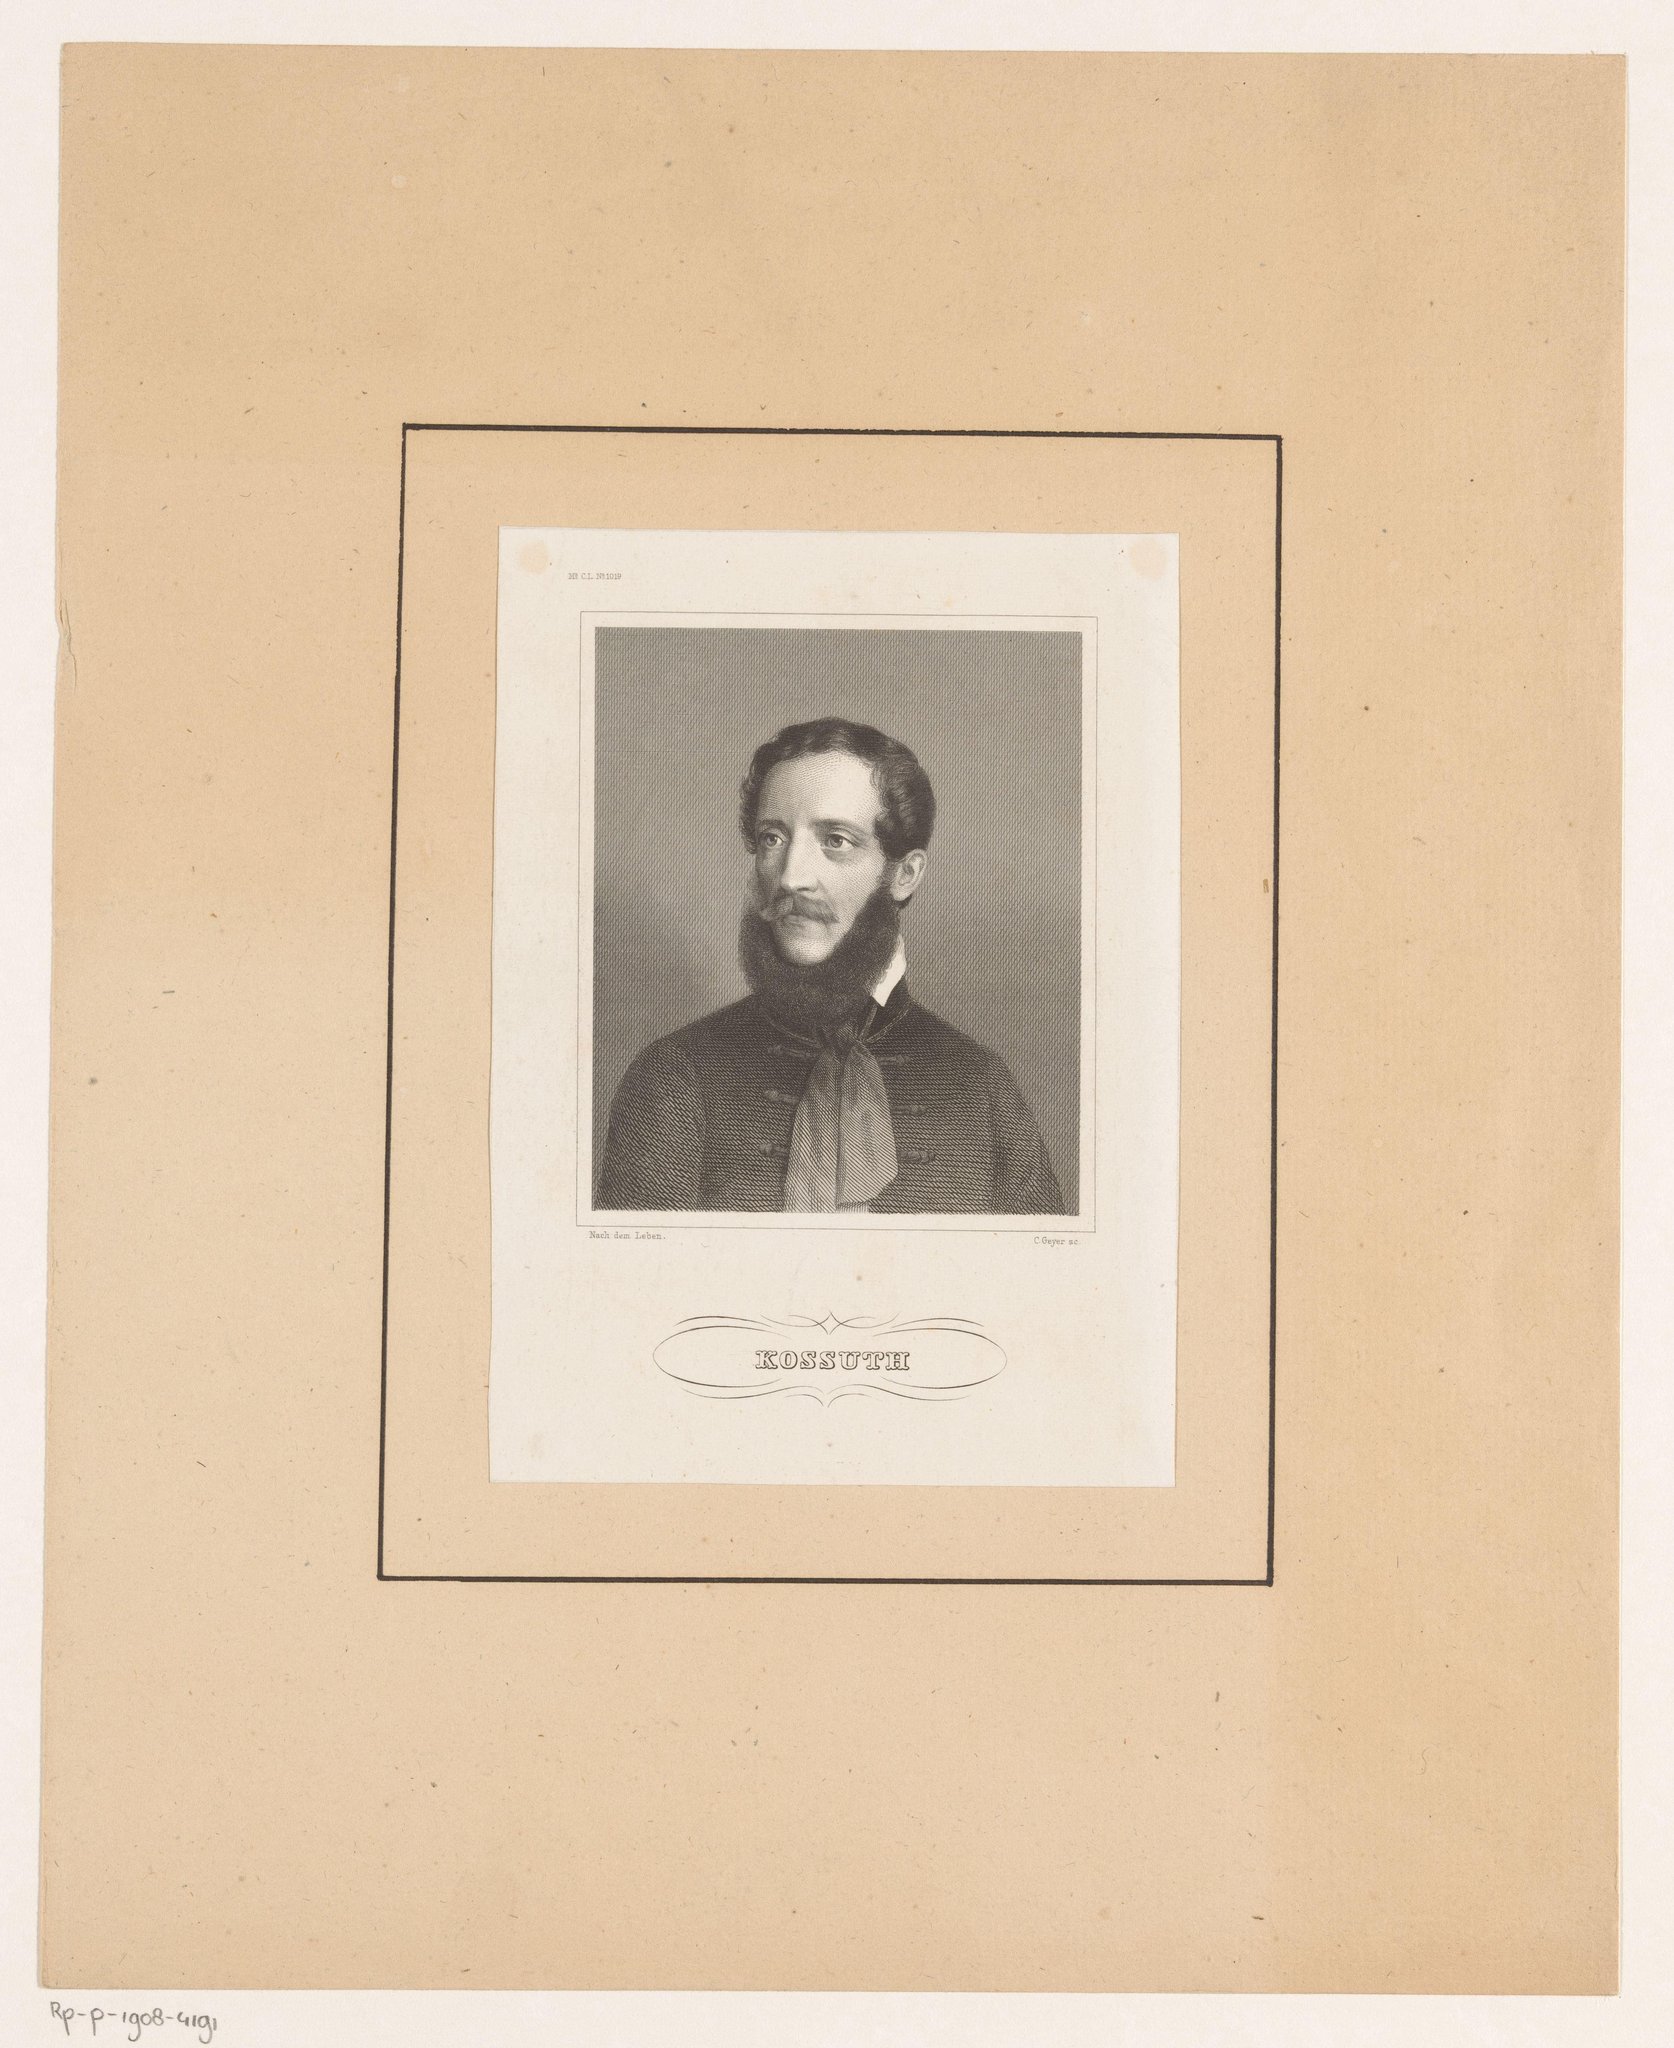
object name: print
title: Portret van Lajos Kossuth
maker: conrad geyer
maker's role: print maker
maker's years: 1816-1893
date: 1840-1855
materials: paper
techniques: engraving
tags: politician, historical persons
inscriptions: collector's mark: Lugt 2228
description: Prent afkomstig uit: Conversations-Lexikon für die gebildeten Stände, voor het eerst uitgegeven tussen 1840-1855.